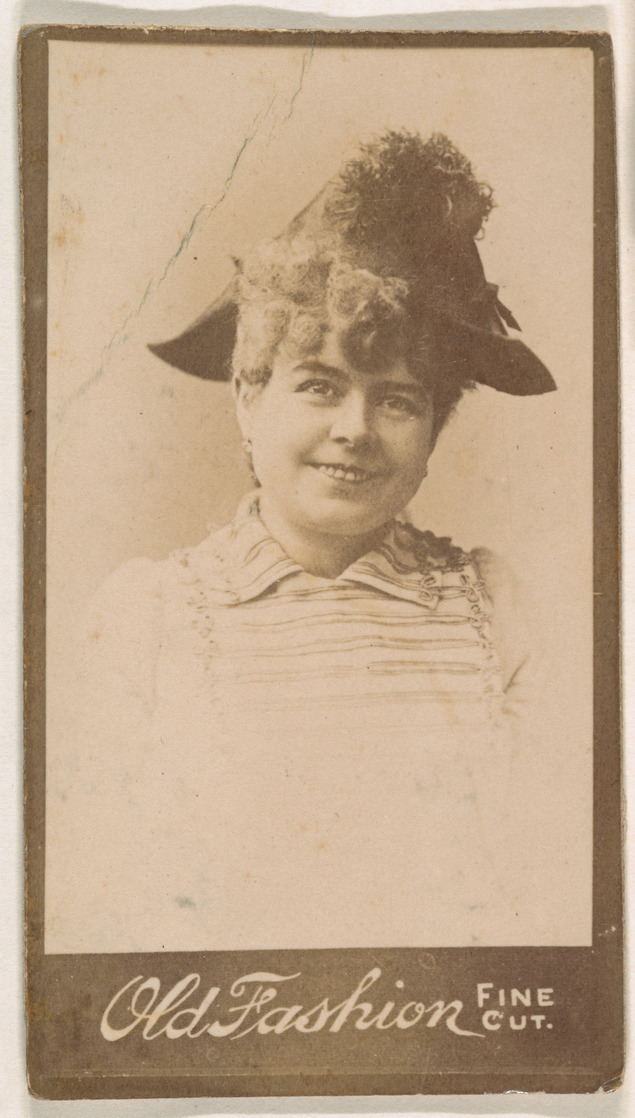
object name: photograph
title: Actress wearing feathered hat, from the Actresses series (N664) promoting Old Fashion Fine Cut Tobacco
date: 1888-1890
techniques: albumen silver print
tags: portraits,women,actresses